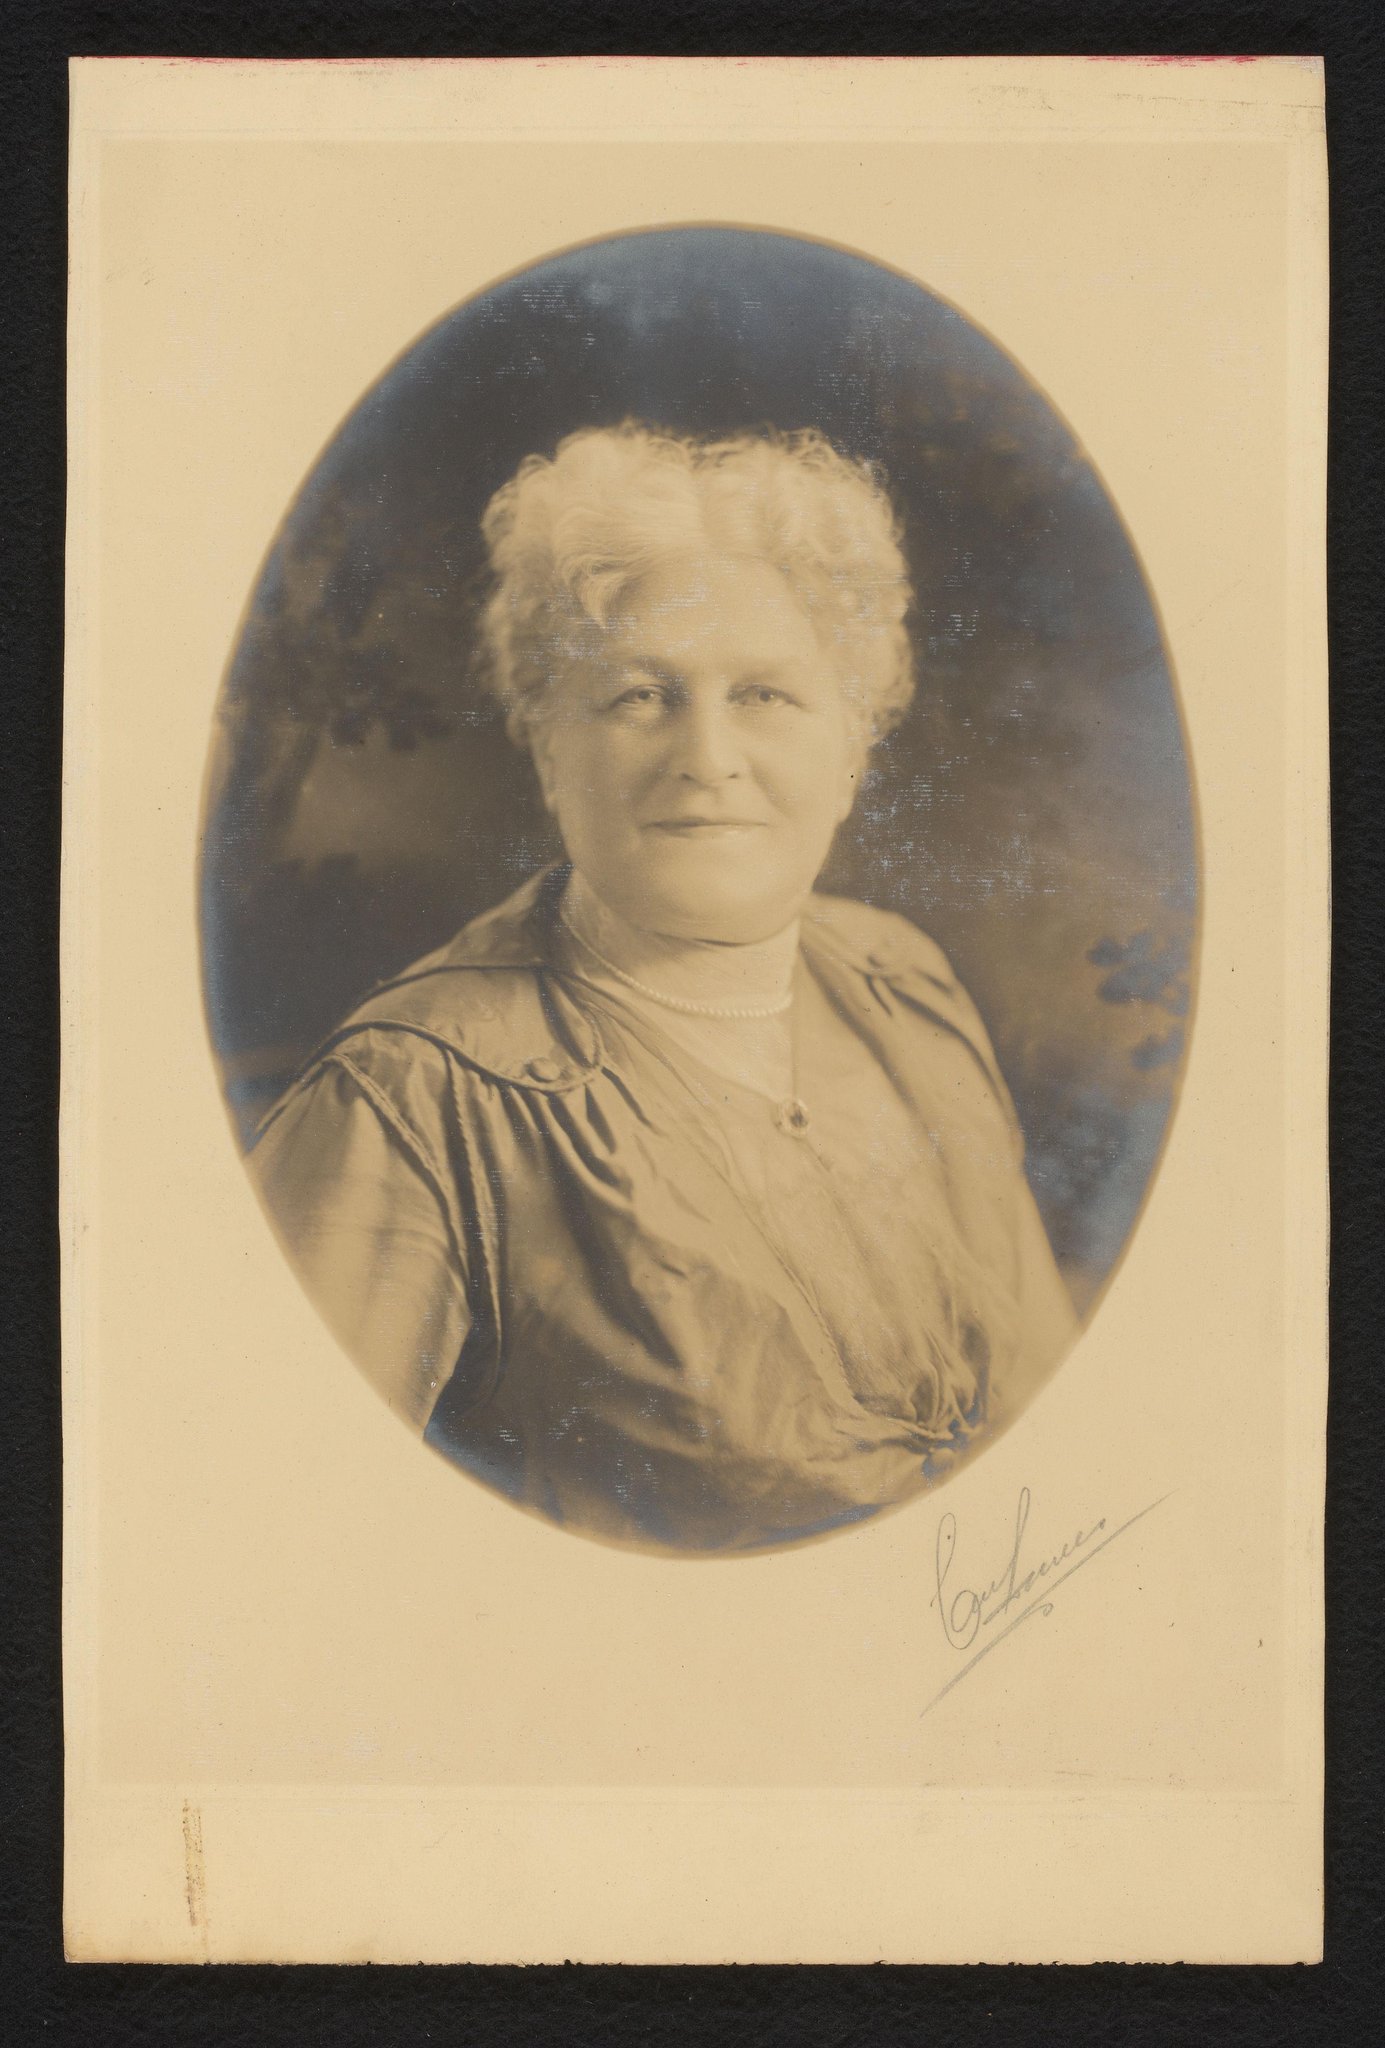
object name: photograph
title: Portret van een vrouw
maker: c.m. hayes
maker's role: fotograaf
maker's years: 1863-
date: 1890-1935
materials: photographic support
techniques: gelatin silver print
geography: detroit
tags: historical persons - bb - woman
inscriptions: inscription: ‘C. M. HAYES & CO,/ DETROIT MICH.’